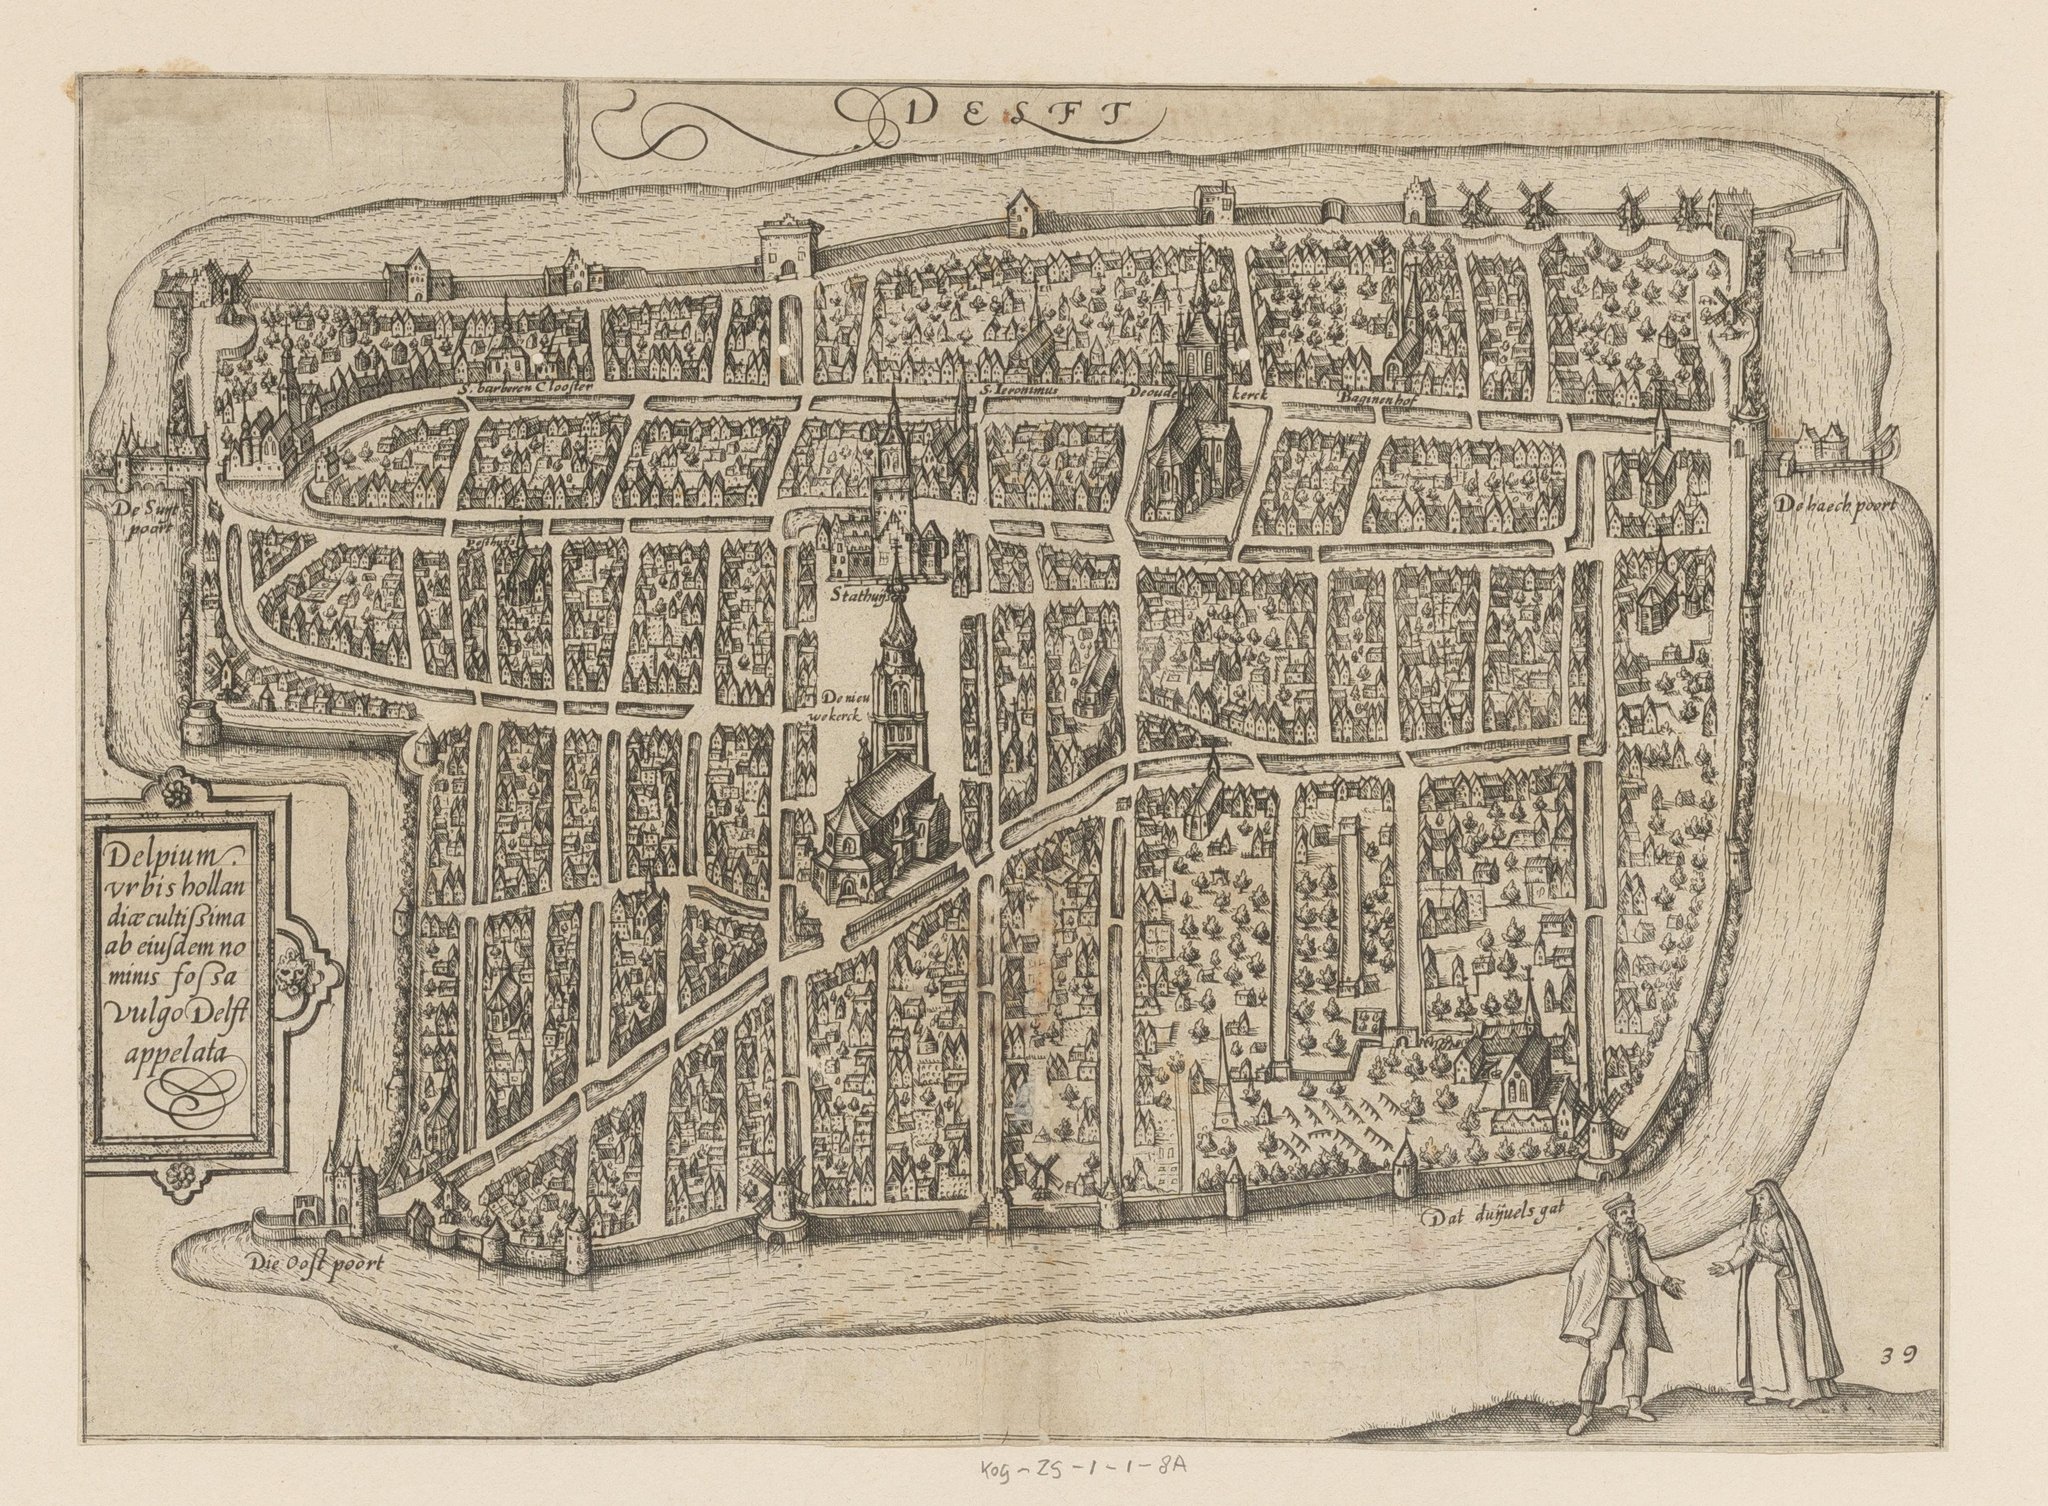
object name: print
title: Delft / Delphium | urbis hollan | diae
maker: Anonymous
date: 1607-1609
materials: paper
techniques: etching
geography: southern netherlands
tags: maps of cities, delft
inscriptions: collector's mark, collector's mark: Lugt 1641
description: Plattegrond van de stad Delft. Midden boven de titel, linksonder een cartouche met de Latijnse titel, rechtsonder een man en een vrouw. Genummerd: 39. Uit een latere editie van: Descrittione di tutti i Paesi Bassi van Lodovico Guicciardini. Onderwerpsrubrieken binnen de Atlas Zeden en Gewoonten: topografie; stadsprofielen.